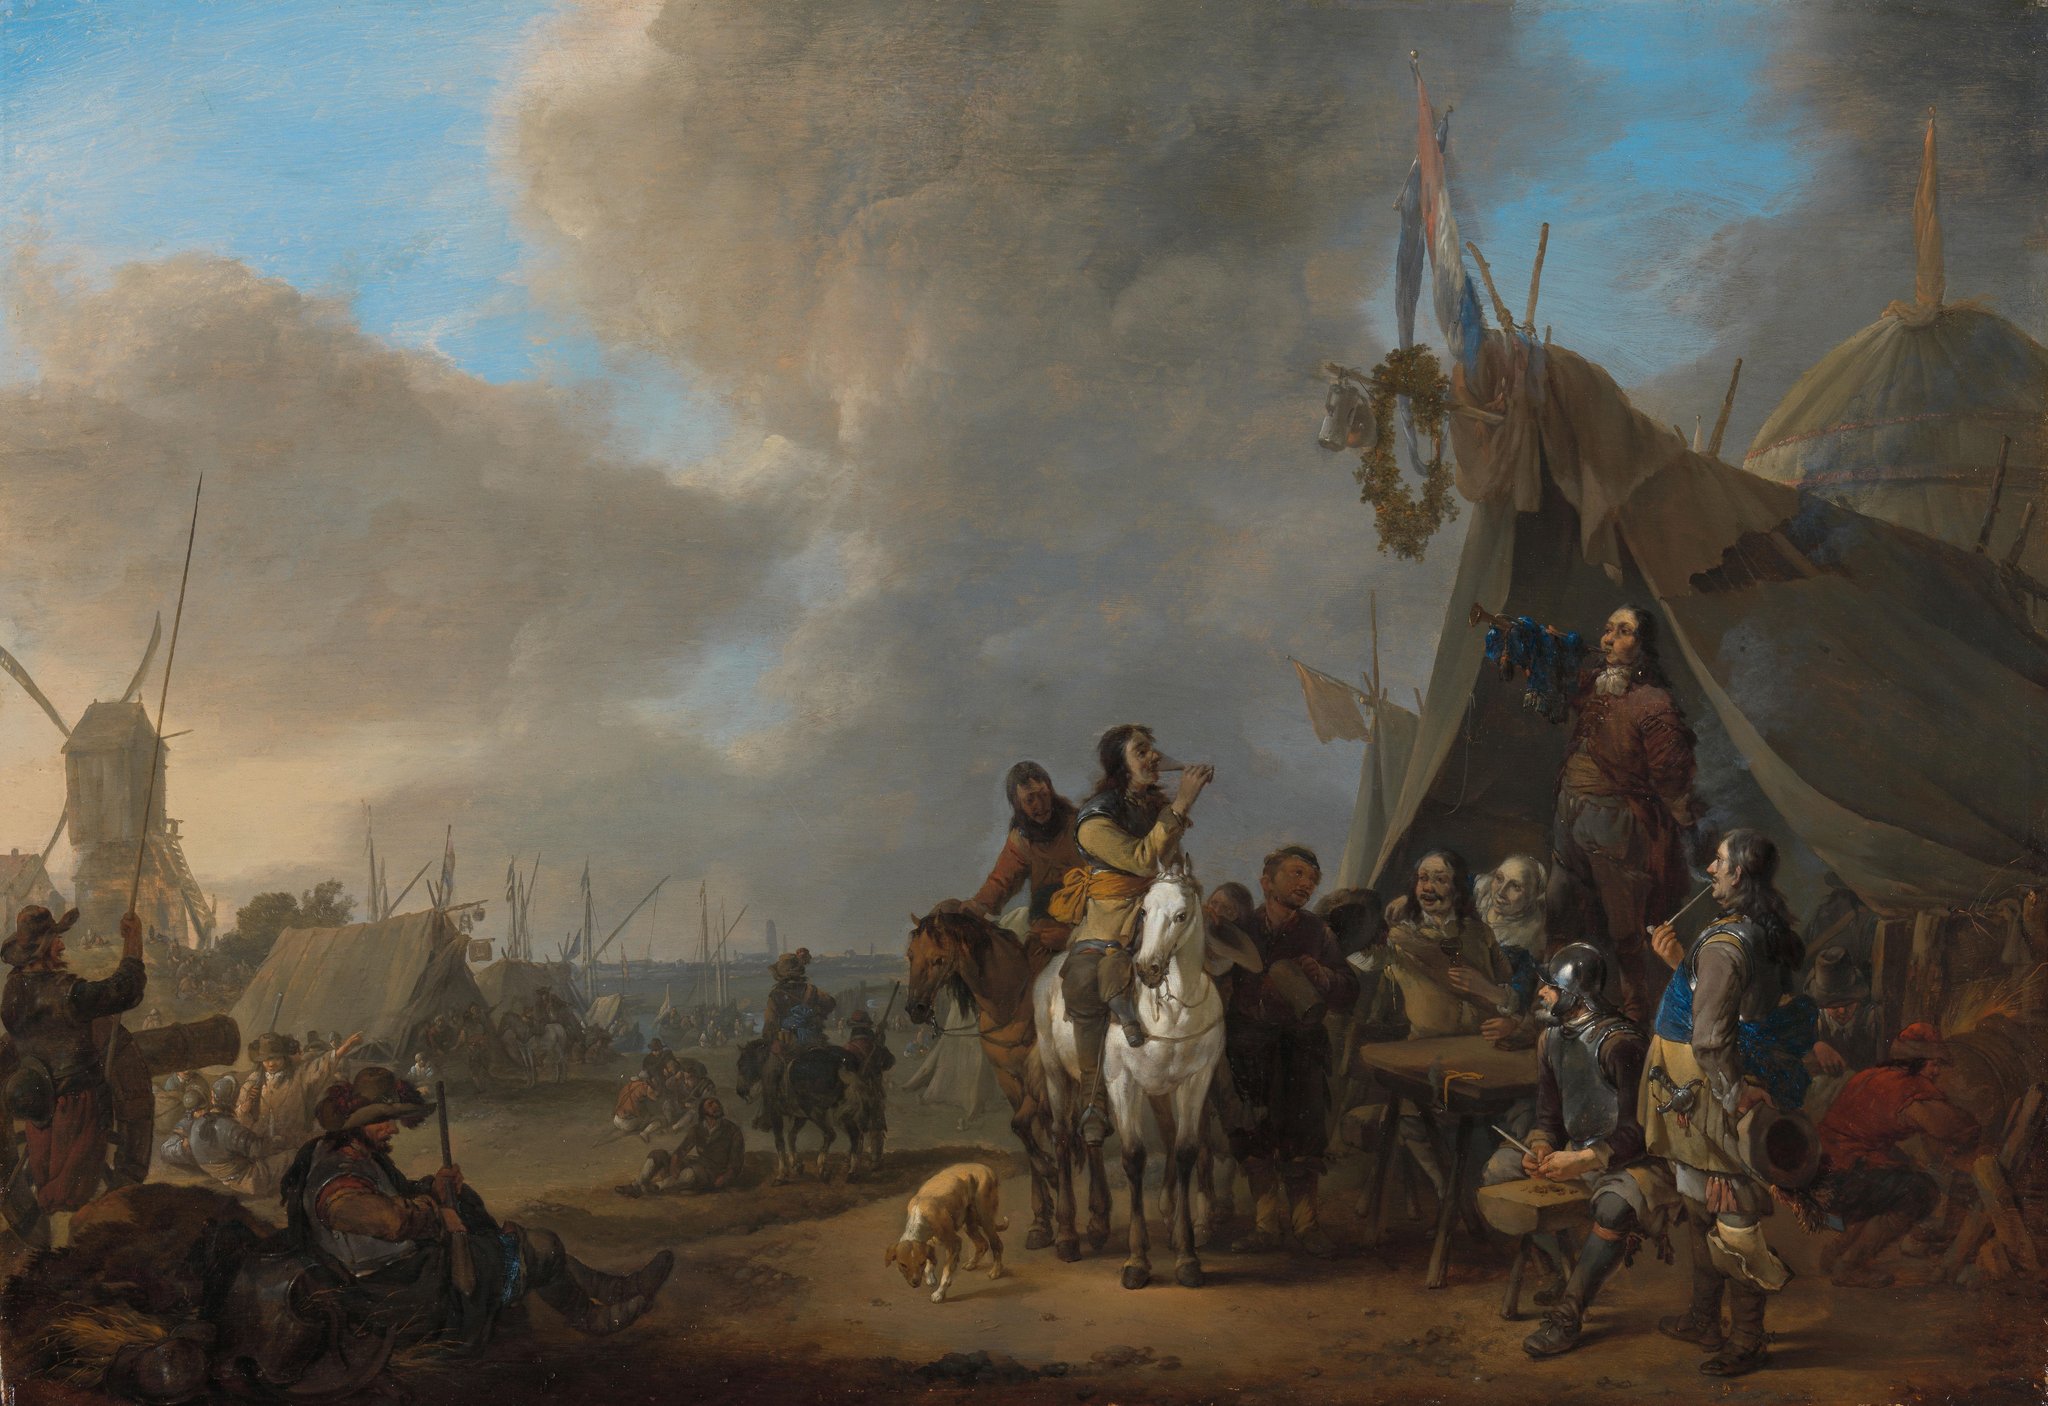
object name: painting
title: Army Camp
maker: johannes lingelbach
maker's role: draughtsman, painter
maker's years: 1622-1674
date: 1650-1674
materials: oil, panel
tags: (military) camp with tents, alcoholic drinks, camp followers, netherlands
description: In een legerplaats drinkt een officier te paard een glas wijn voor een met vaandel, krans en bierkruik versierde tent. Voor de tent is een vrolijk gezelschap verzameld, een officier staat op de tafel en blaast op een trompet. Links andere tenten in het kamp, op de voorgrond links maakt een soldaat zijn geweer schoon.